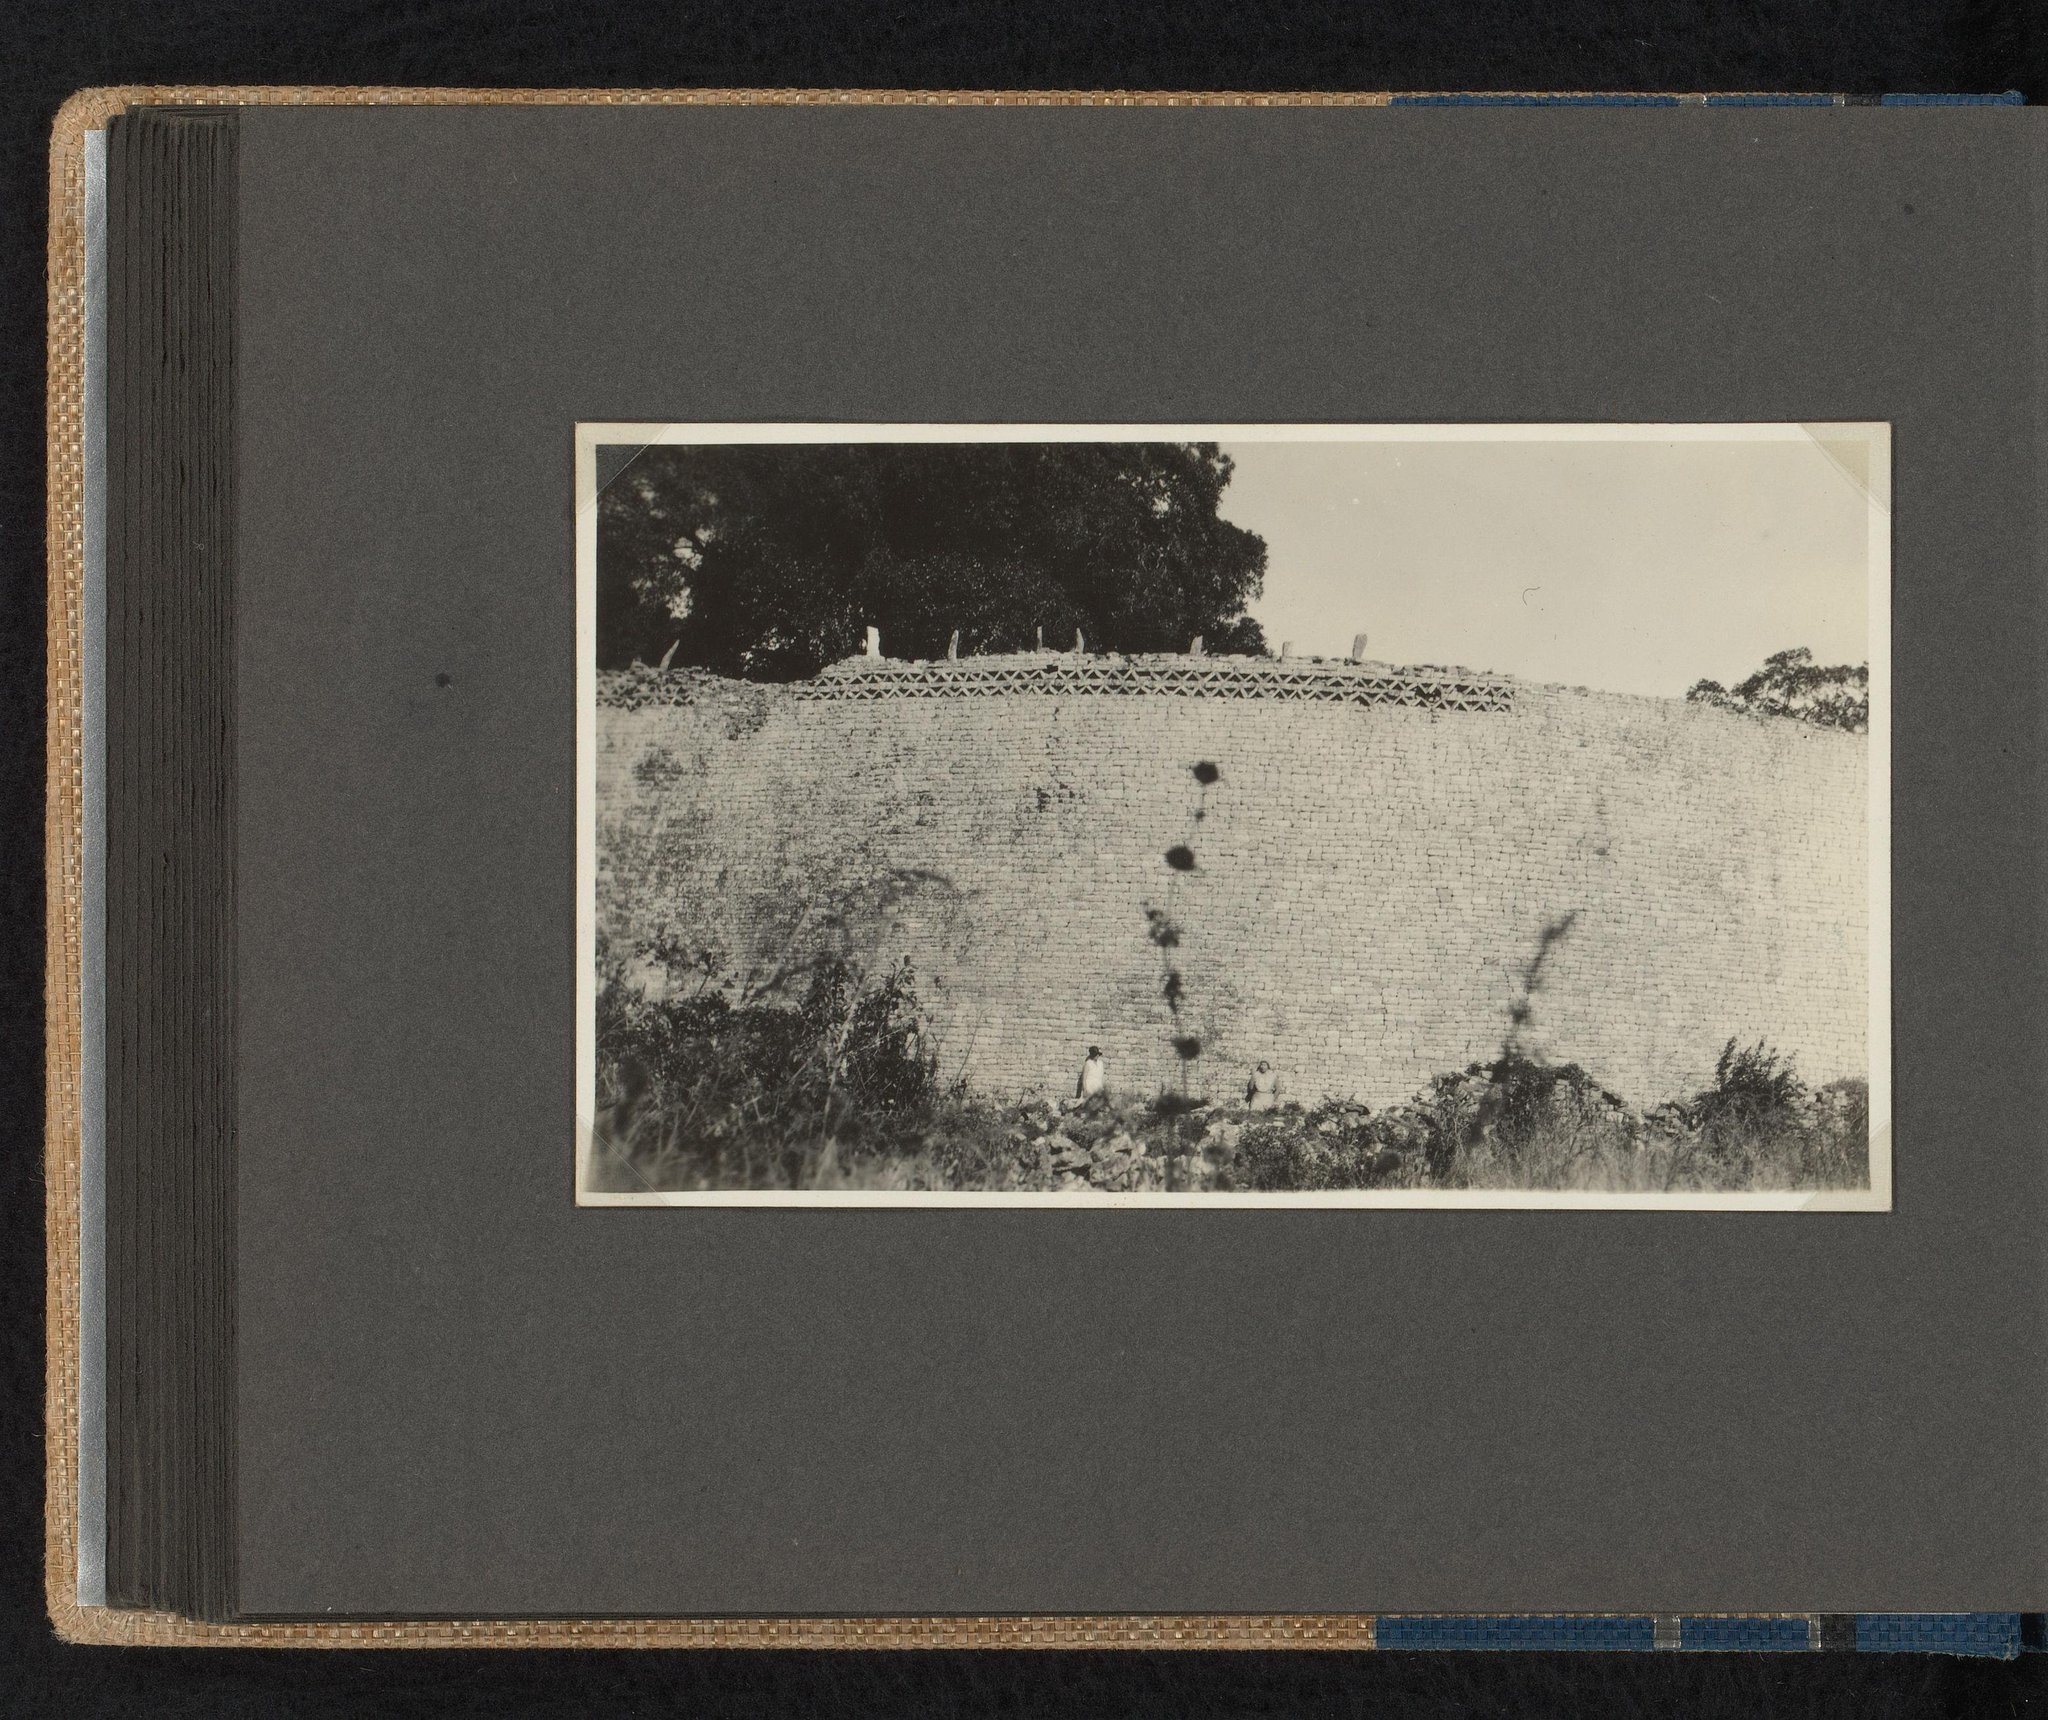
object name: album leaf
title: Twee vrouwen tegen een hoge stenen muur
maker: karel frederik van den berg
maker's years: 1873-1948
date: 1920-1930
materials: paper, cardboard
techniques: gelatin silver print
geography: south africa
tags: fence, wall, paling